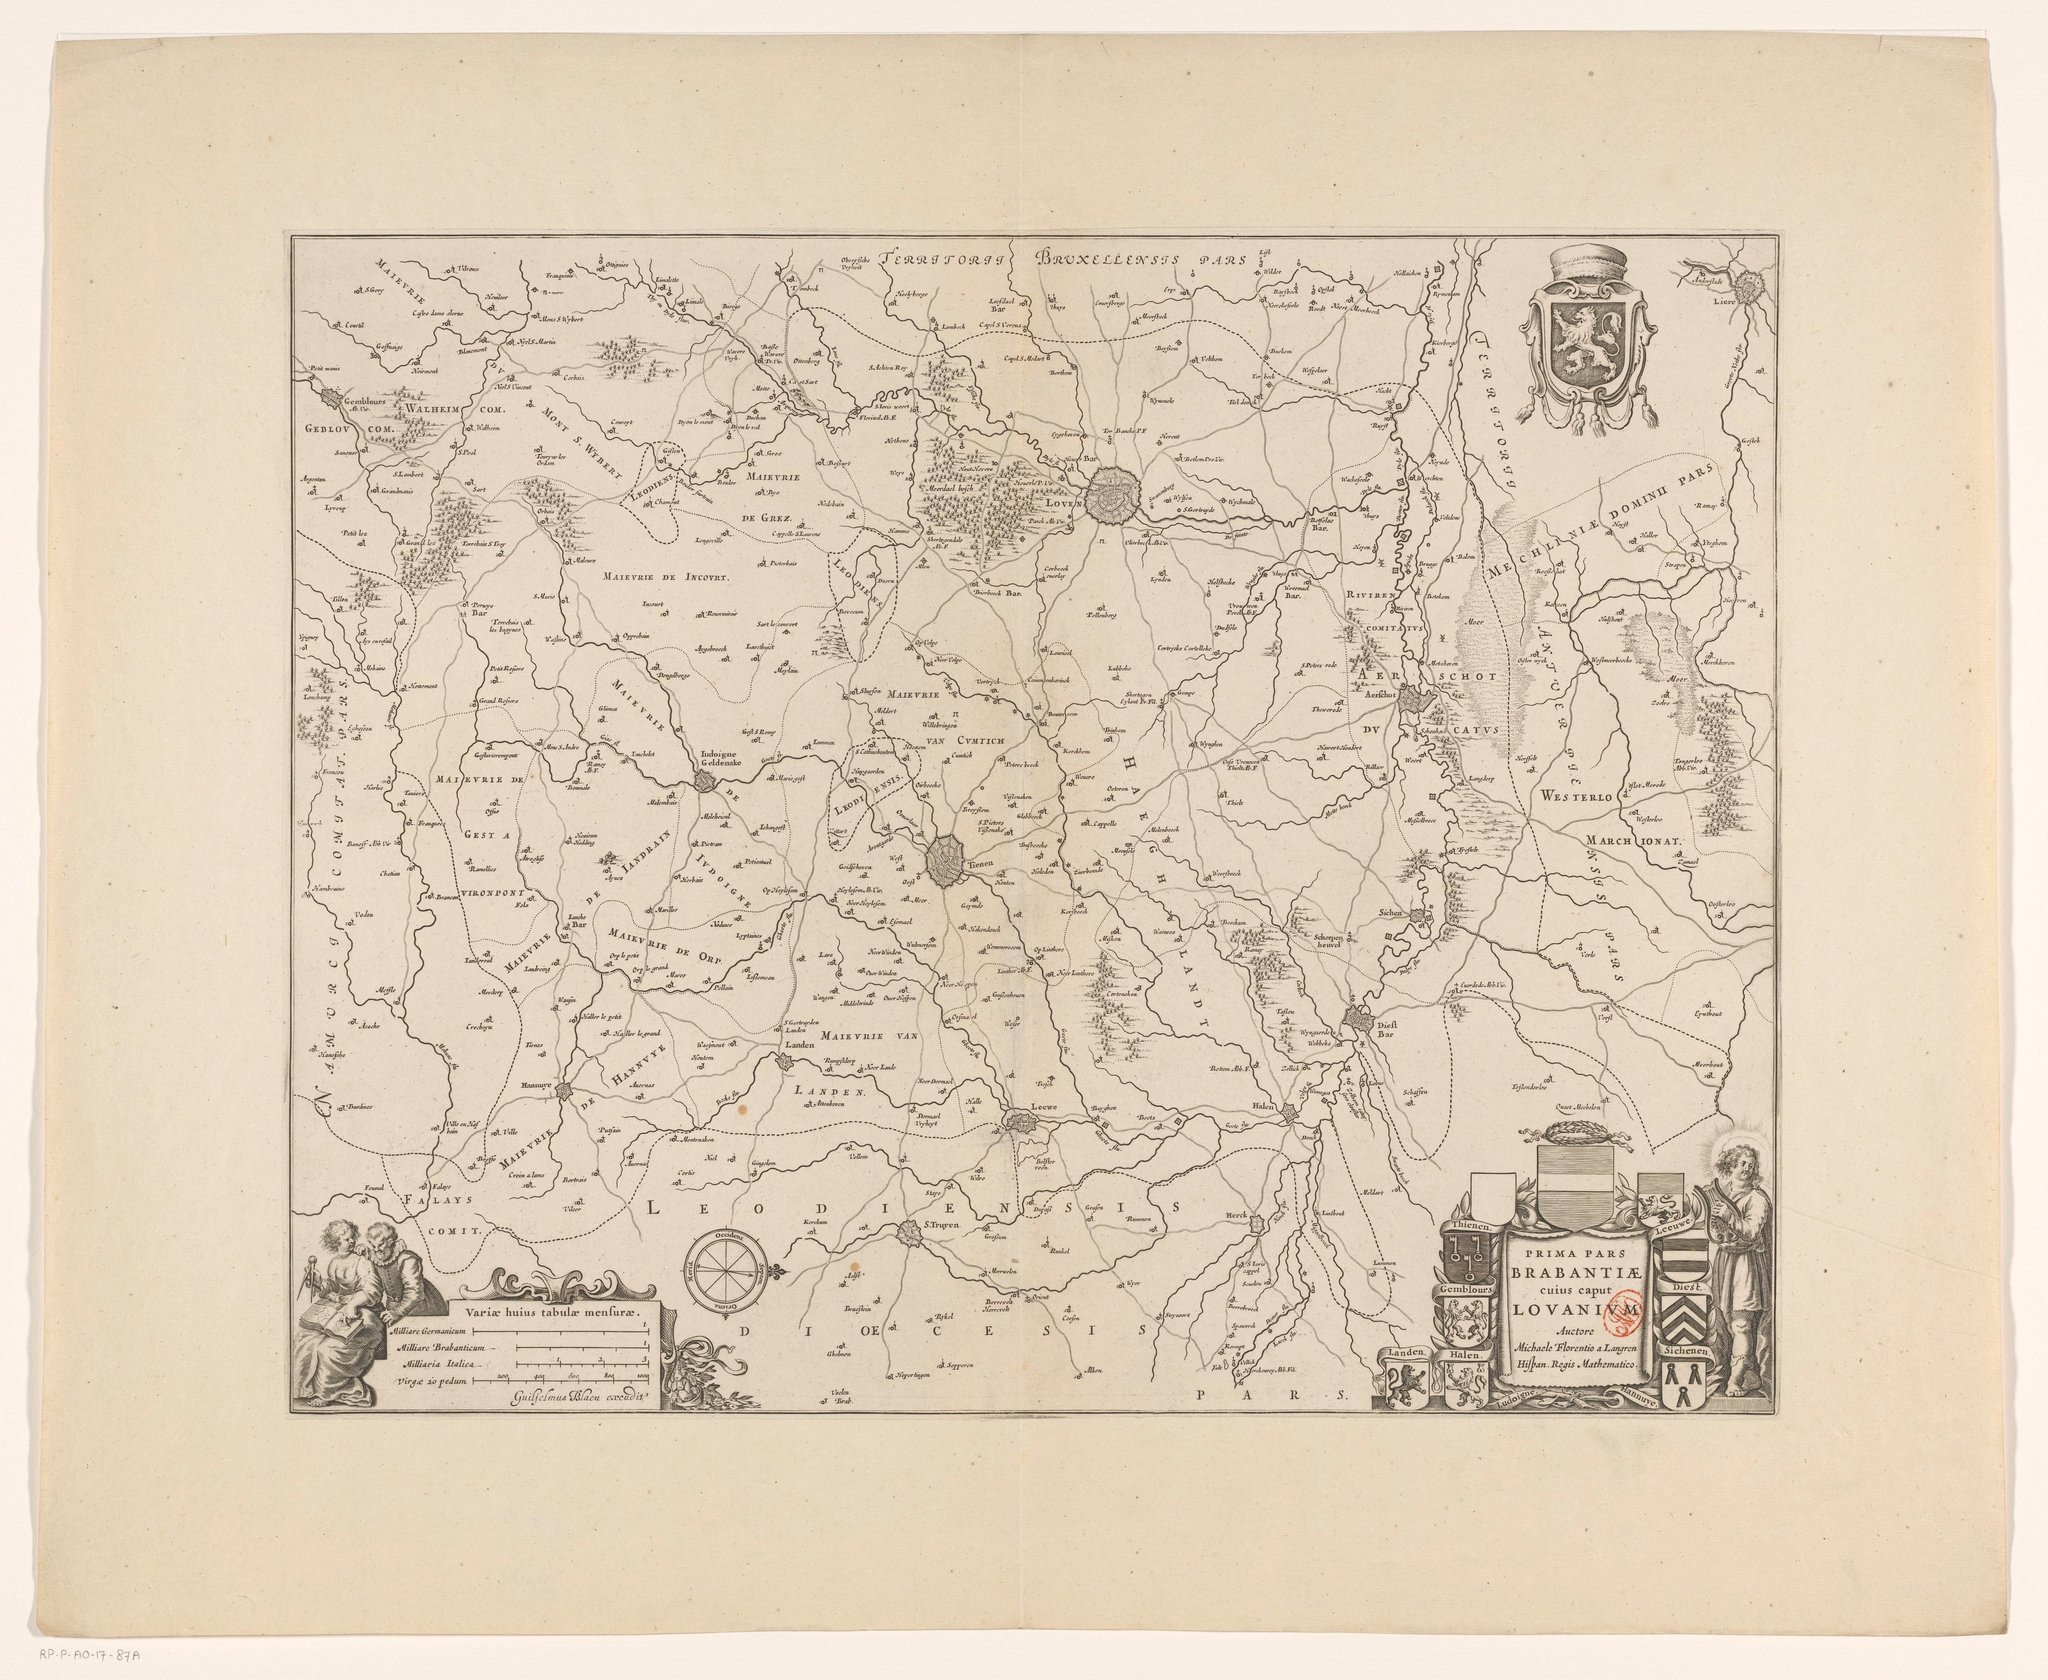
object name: map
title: Kaart van het kwartier van Leuven, onderdeel van het hertogdom Brabant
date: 1642-1672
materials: paper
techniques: engraving, etching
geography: amsterdam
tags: coat of arms (as symbol of the state, etc.) (+ city; municipal), maps of separate countries or regions, coat of arms (as symbol of the state, etc.) (+ province; provincial), brabant, louvain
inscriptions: collector's mark: Lugt 195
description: Kaart van het kwartier van Leuven, één van de vier kwartieren waarin het hertogdom Brabant is verdeeld. Rechtsonder de titelcartouche met daar omheen de wapens van de steden Landen, Geldenaken, Halen, Gembloers, Leuven, (Zout)leeuw, Diest, Zichem en Hannuit. Rechtsboven het wapen van Brabant. Linksonder een cartouche met vier schaalstokken: 1 Milliare Germanicum / 1 Milliare Brabanticum, en twee andere.